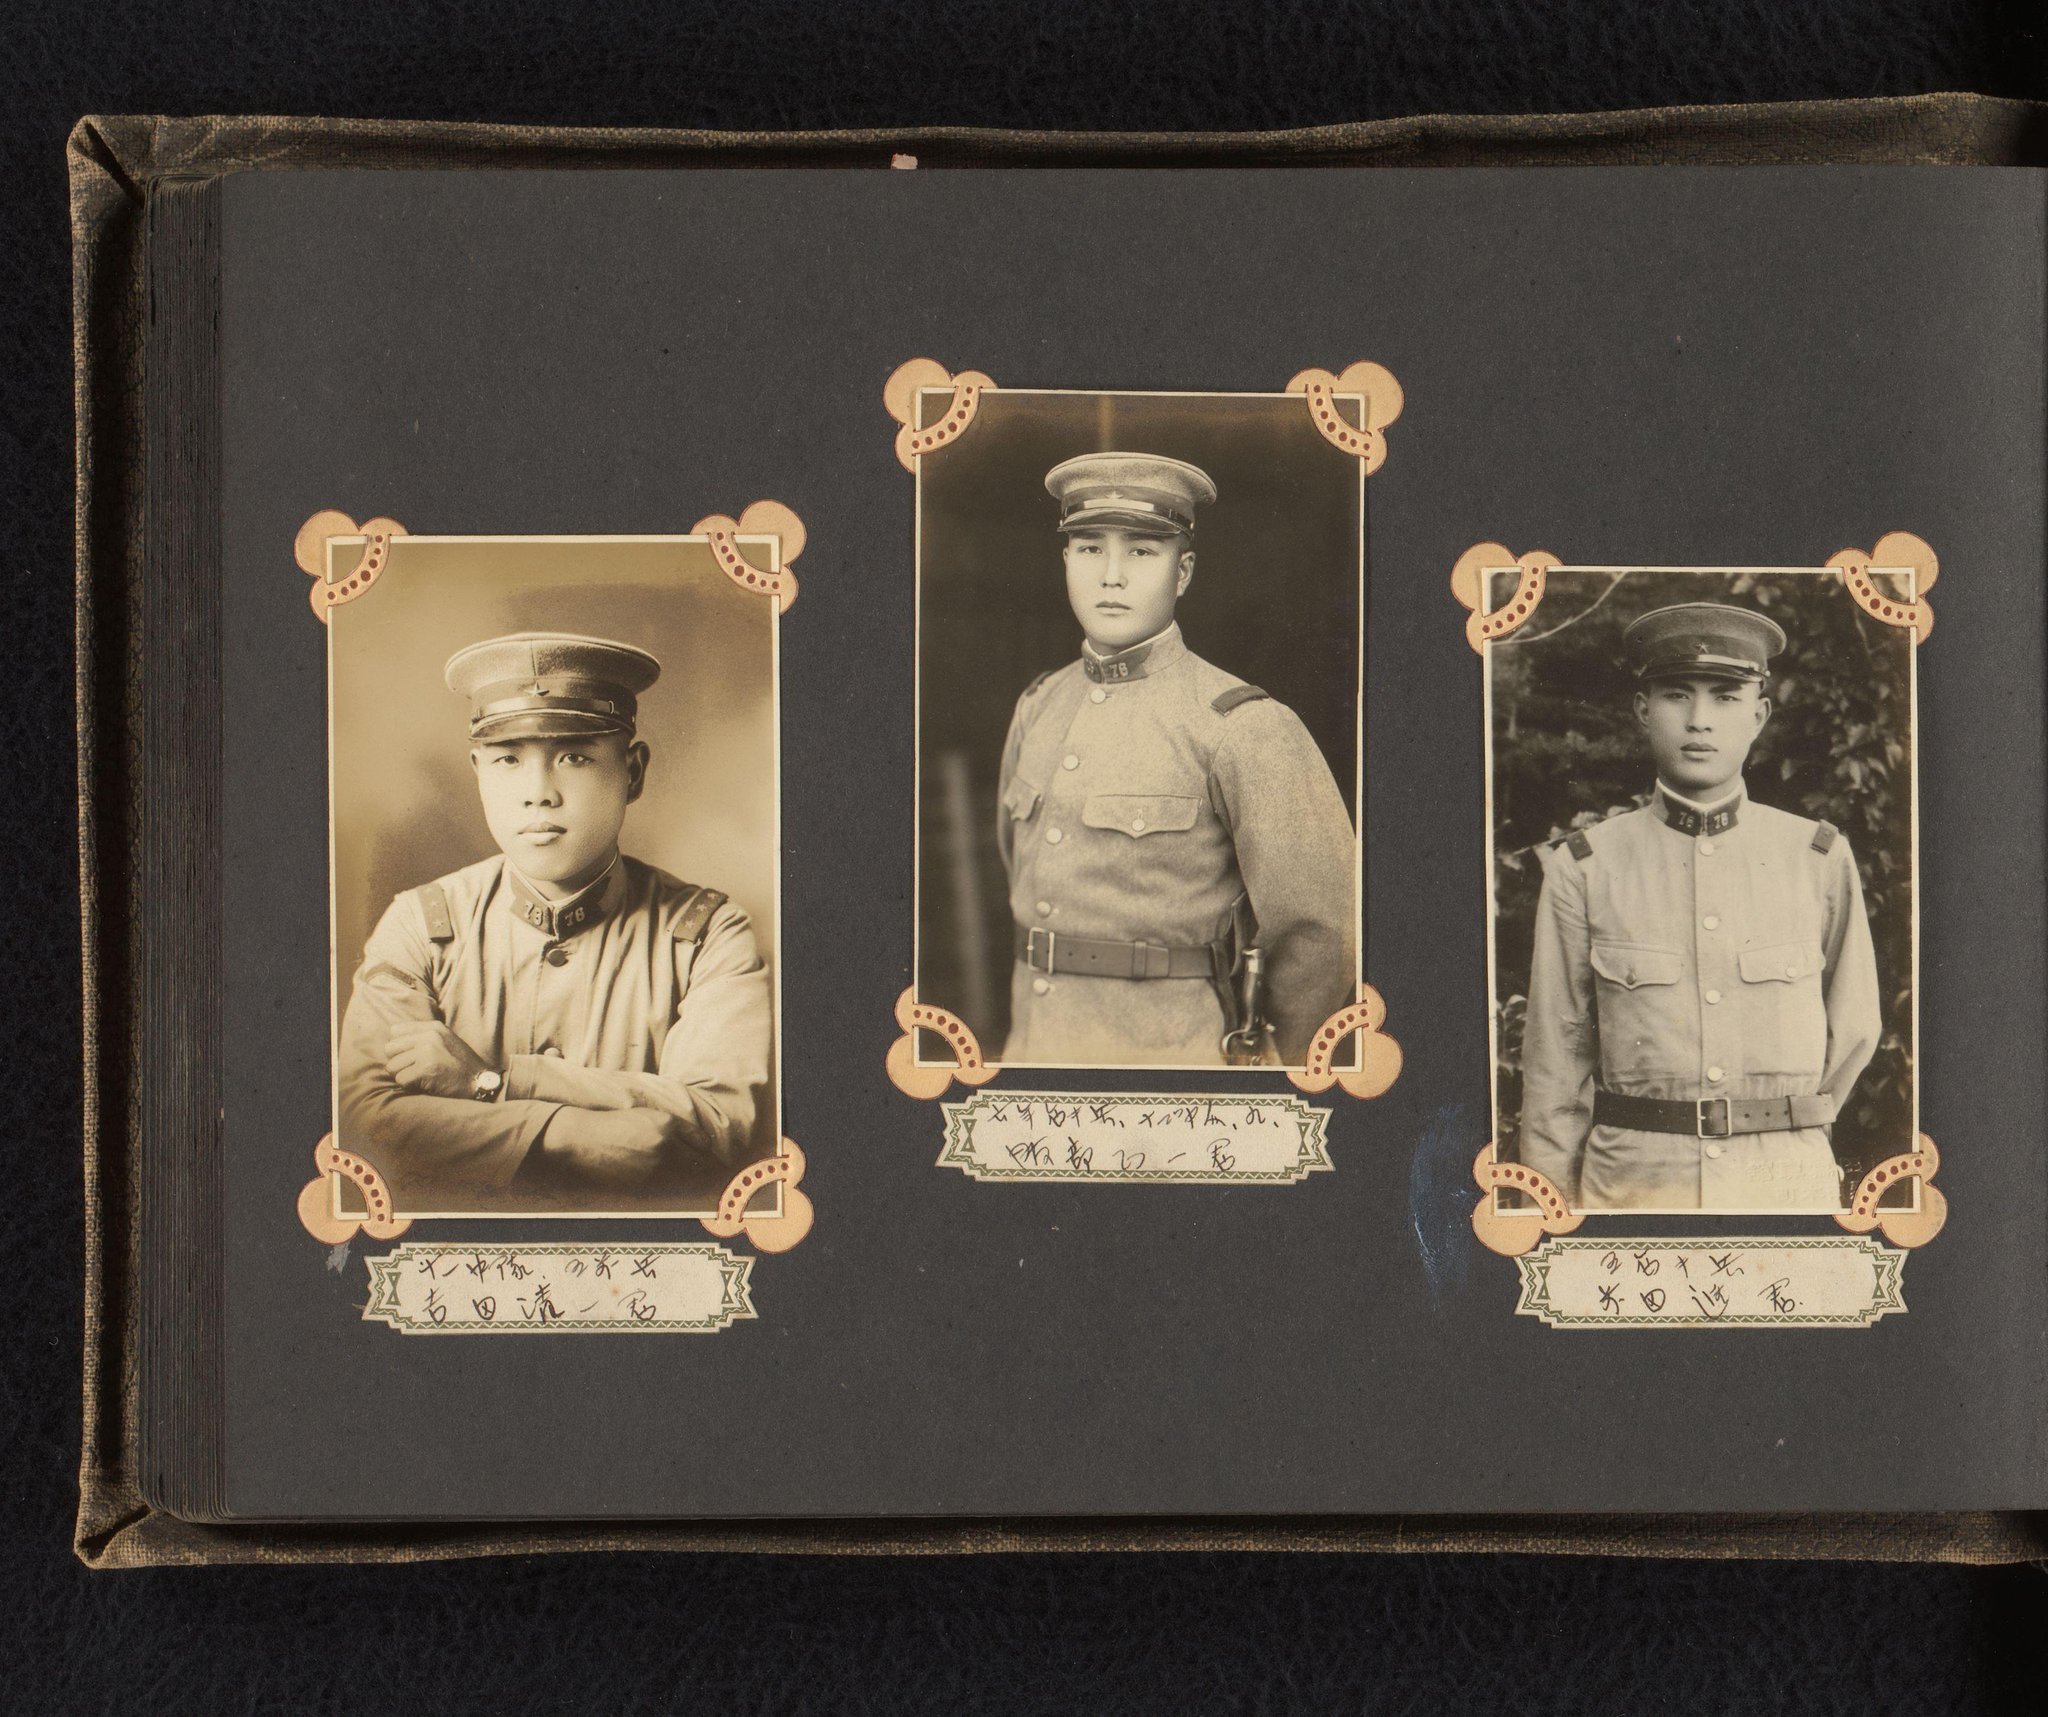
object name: album leaf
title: Drie portretten van onbekende Japanse soldaten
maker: Anonymous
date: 1930-1940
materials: paper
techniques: gelatin silver print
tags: anonymous historical person portrayed, the soldier; the soldier's life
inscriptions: inscription: ‘[...]’